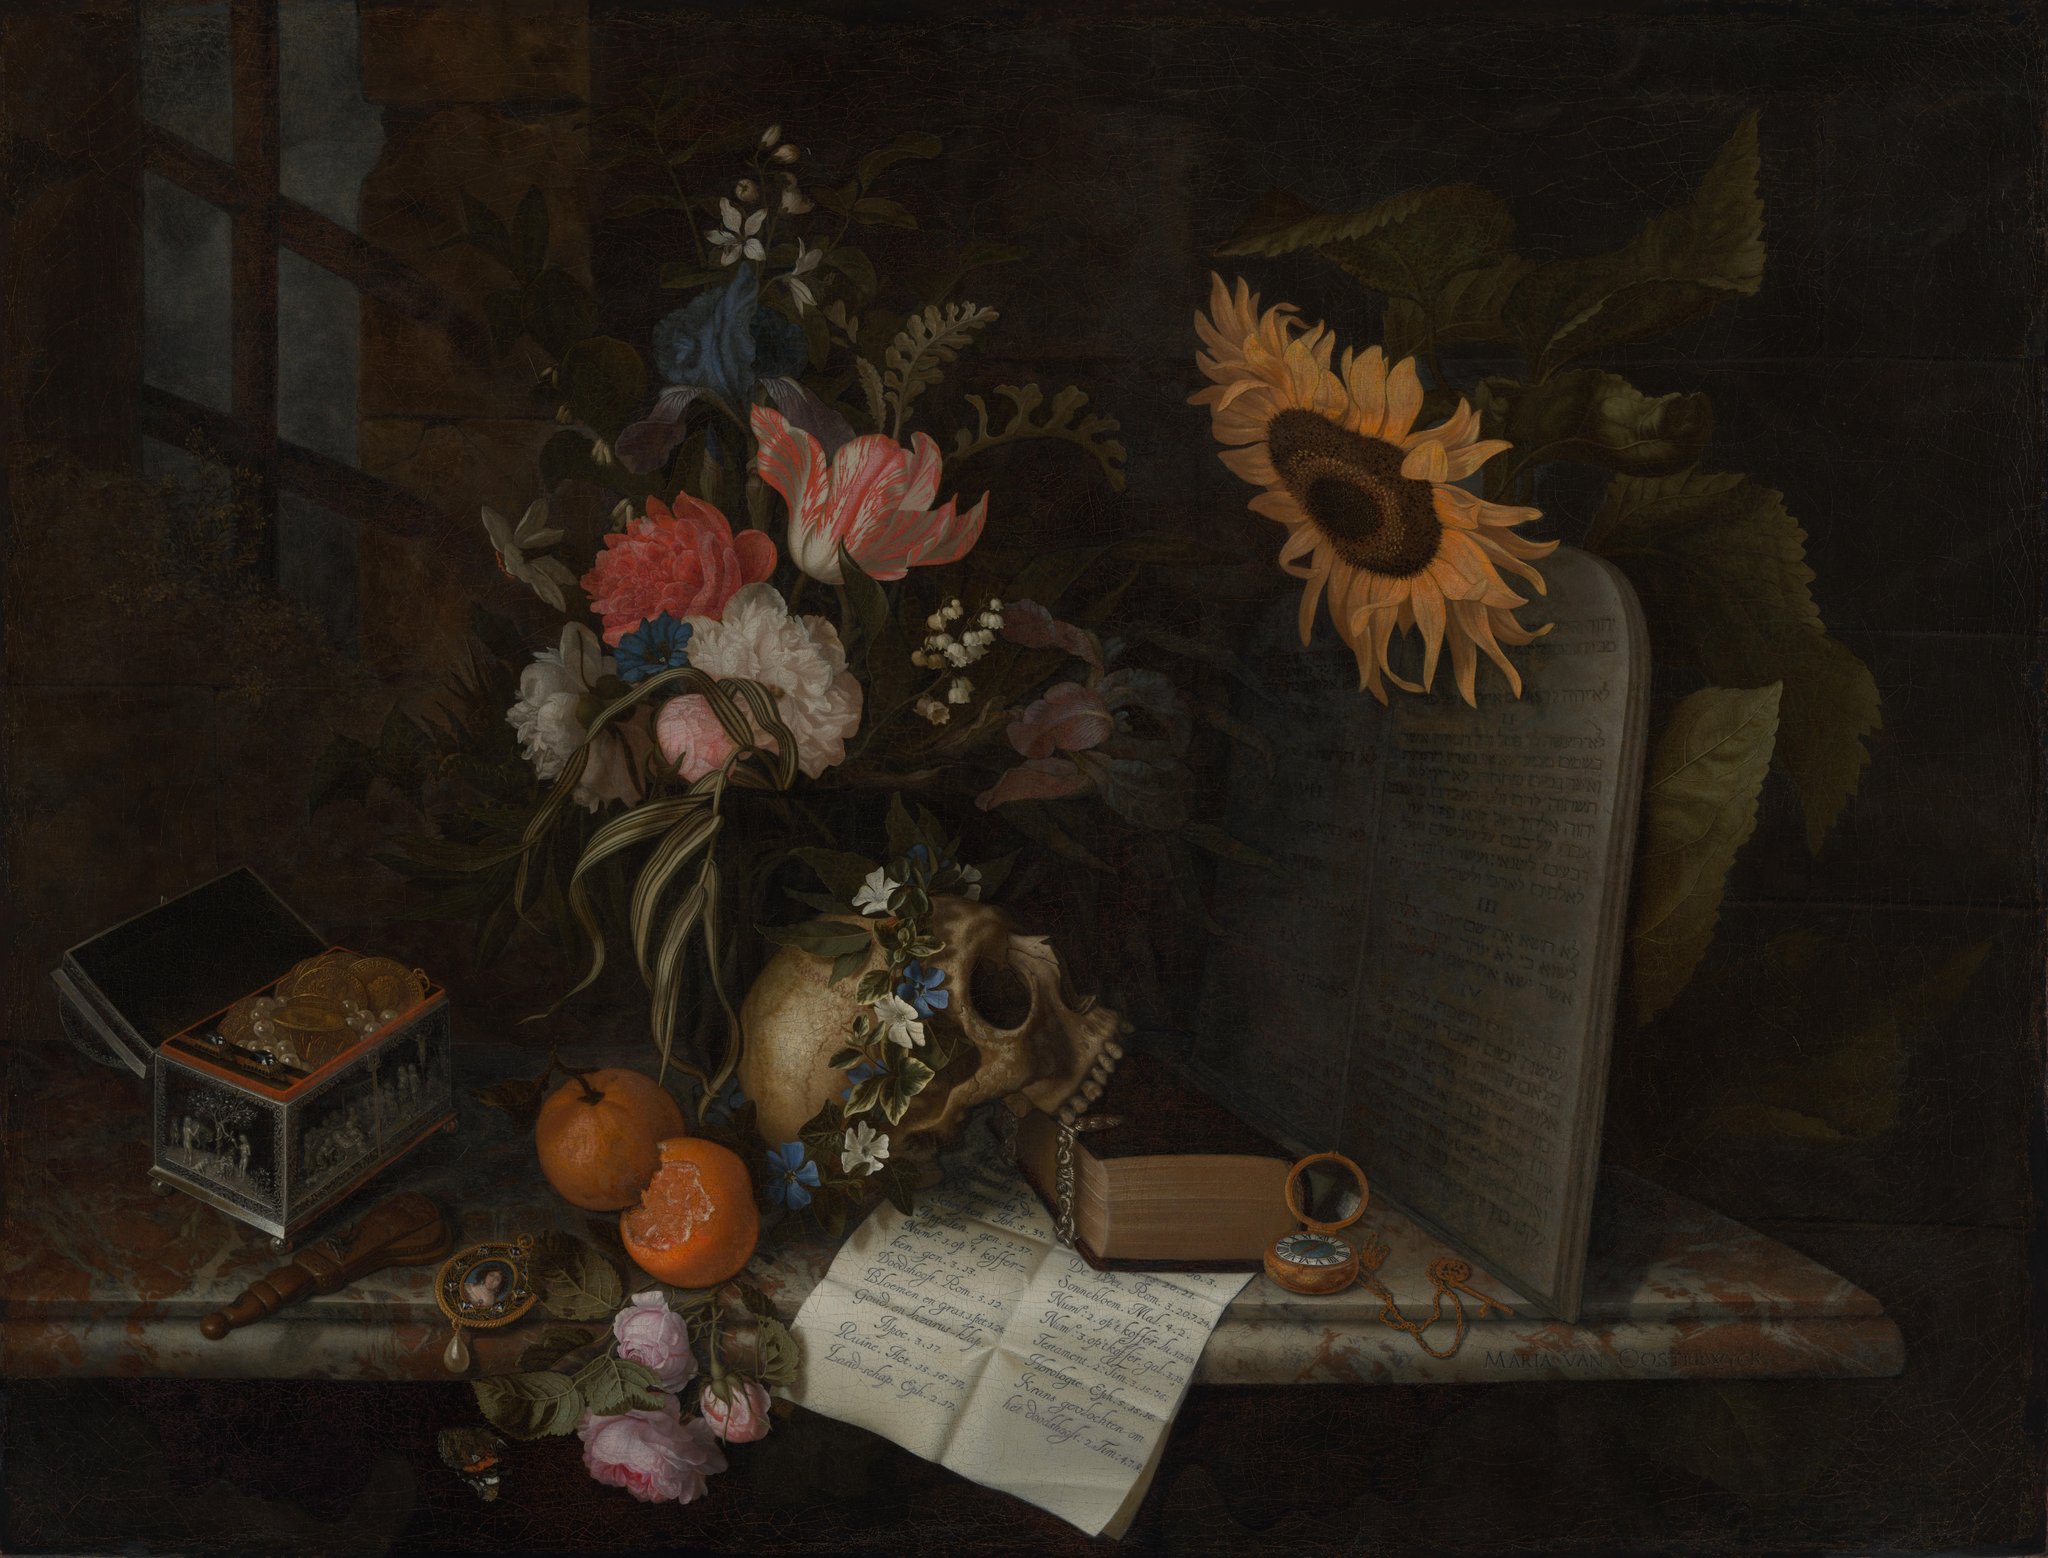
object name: painting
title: Vanitas stilleven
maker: maria van oosterwijck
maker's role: painter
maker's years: 1623-1693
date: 1675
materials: canvas, oil, paint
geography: amsterdam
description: Op een stenen tafel staat in het midden een vaas met bloemen, daarom heen is een groot aantal objecten geplaatst. Links staat een kistje dat voornamelijk met gouden munten is gevuld, daarnaast ligt een ratelaar, een medaillon, twee sinaasappels, een takje met rozen, een doodshoofd met een bloemenkrans, een boek, een horloge, de twee stenen tafelen met de tien geboden en een zonnebloem. Voorop ligt nog een blad papier waarop de geschilderde objecten worden genoemd met daarachter een verwijzing naar een Bijbeltekst. Links op de achtergrond is een getralied raam zichtbaar.